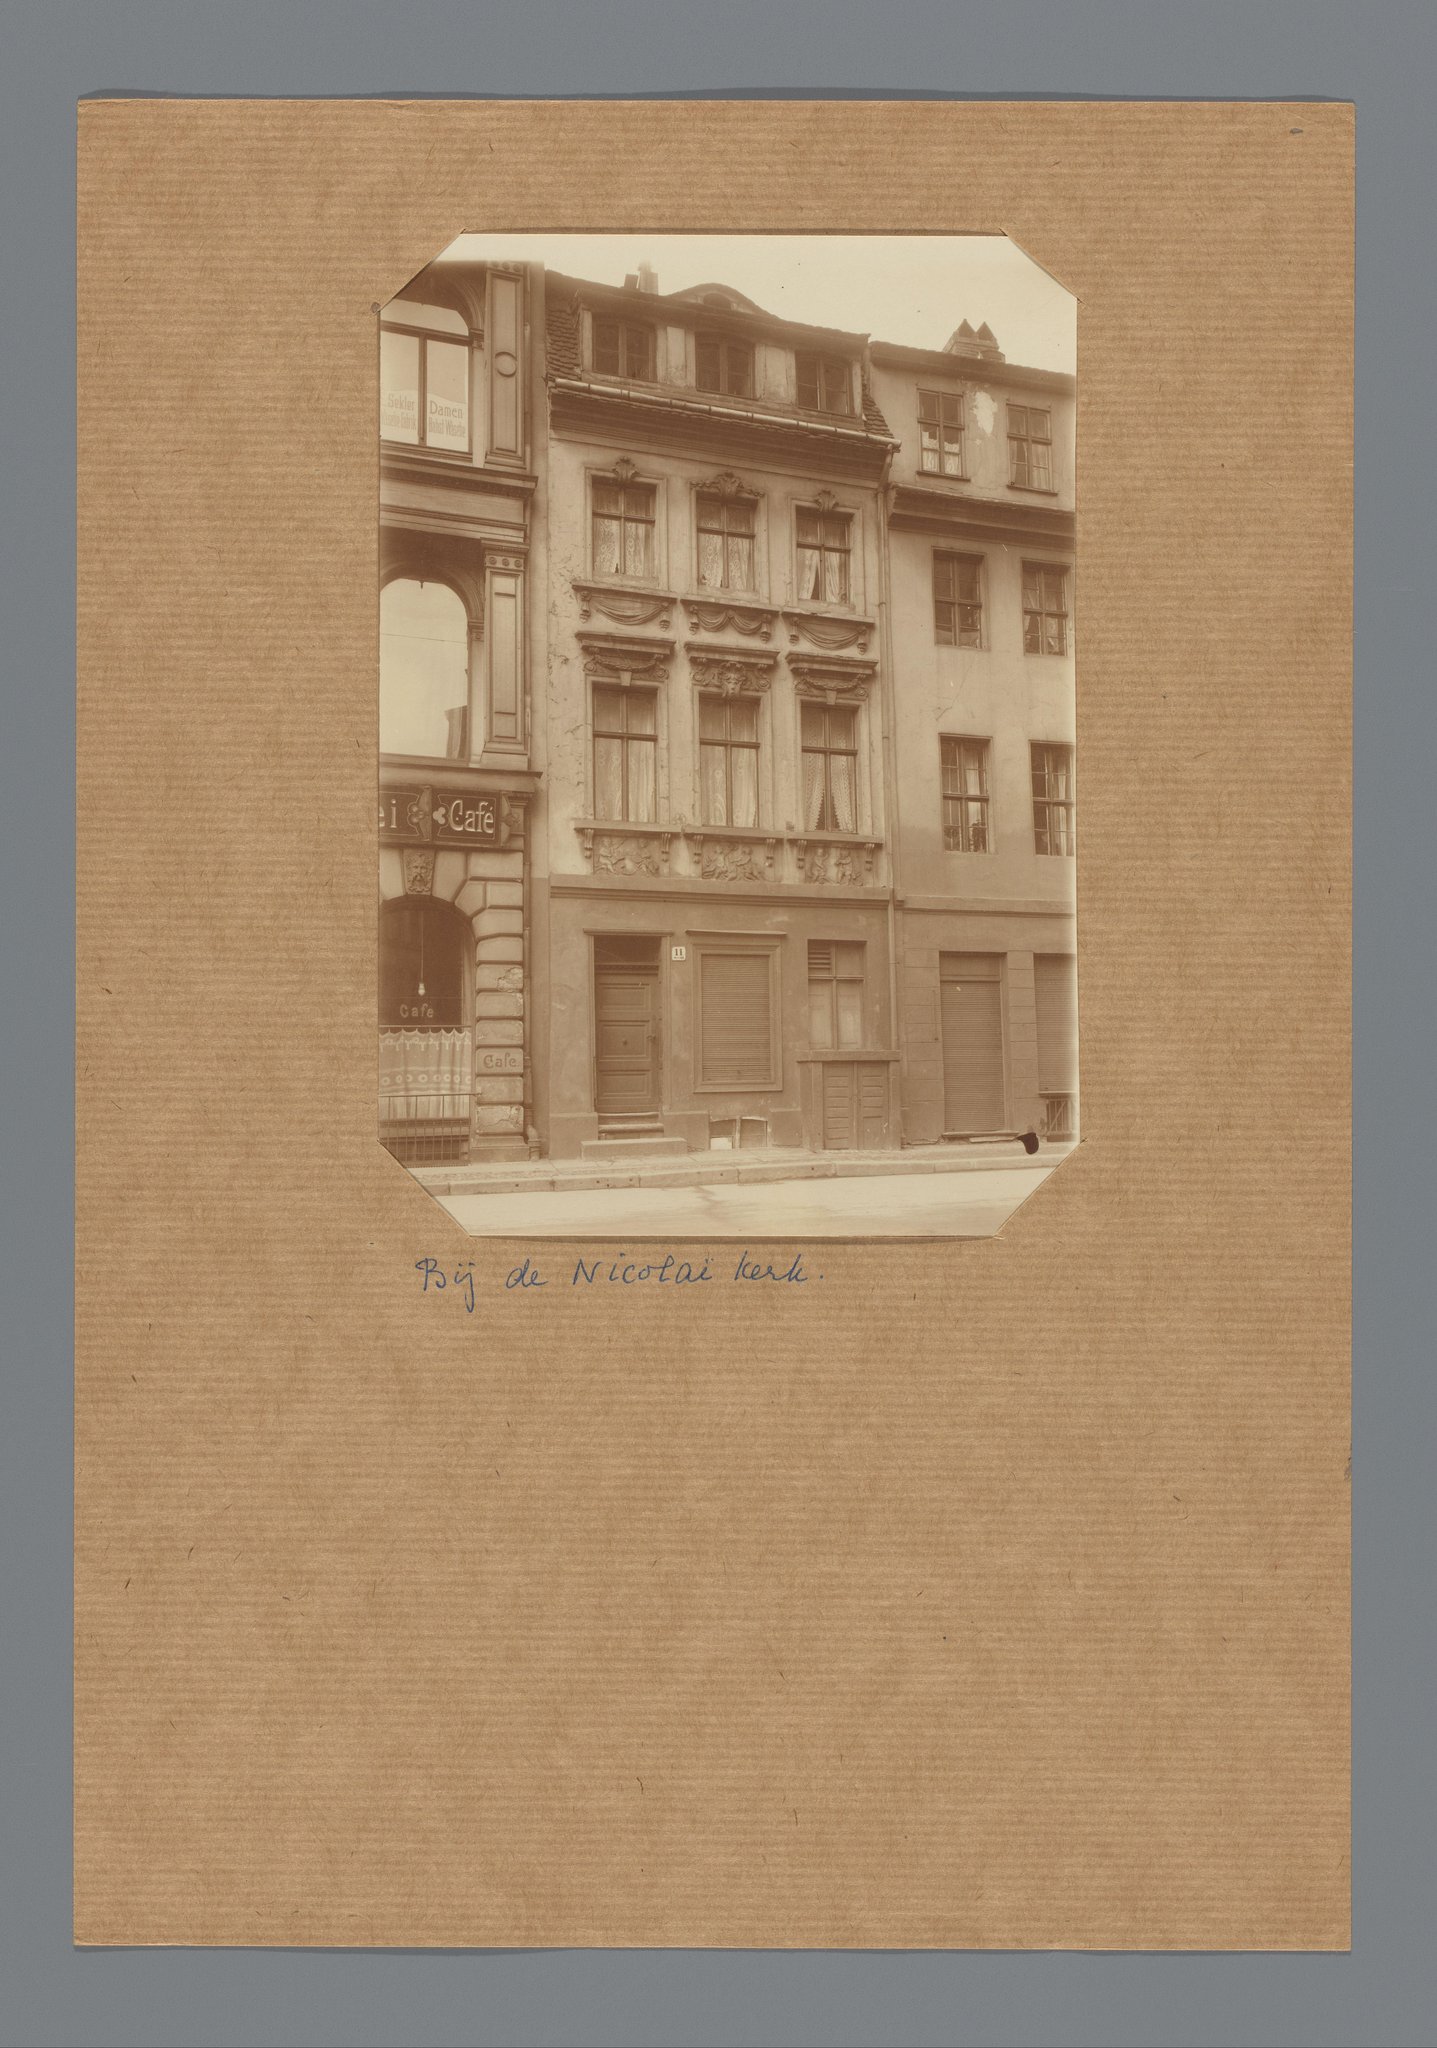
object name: photograph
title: Berlijn. Bij de Nicolaikirche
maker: Anonymous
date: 1880-1920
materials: photographic support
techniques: gelatin silver print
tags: berlin